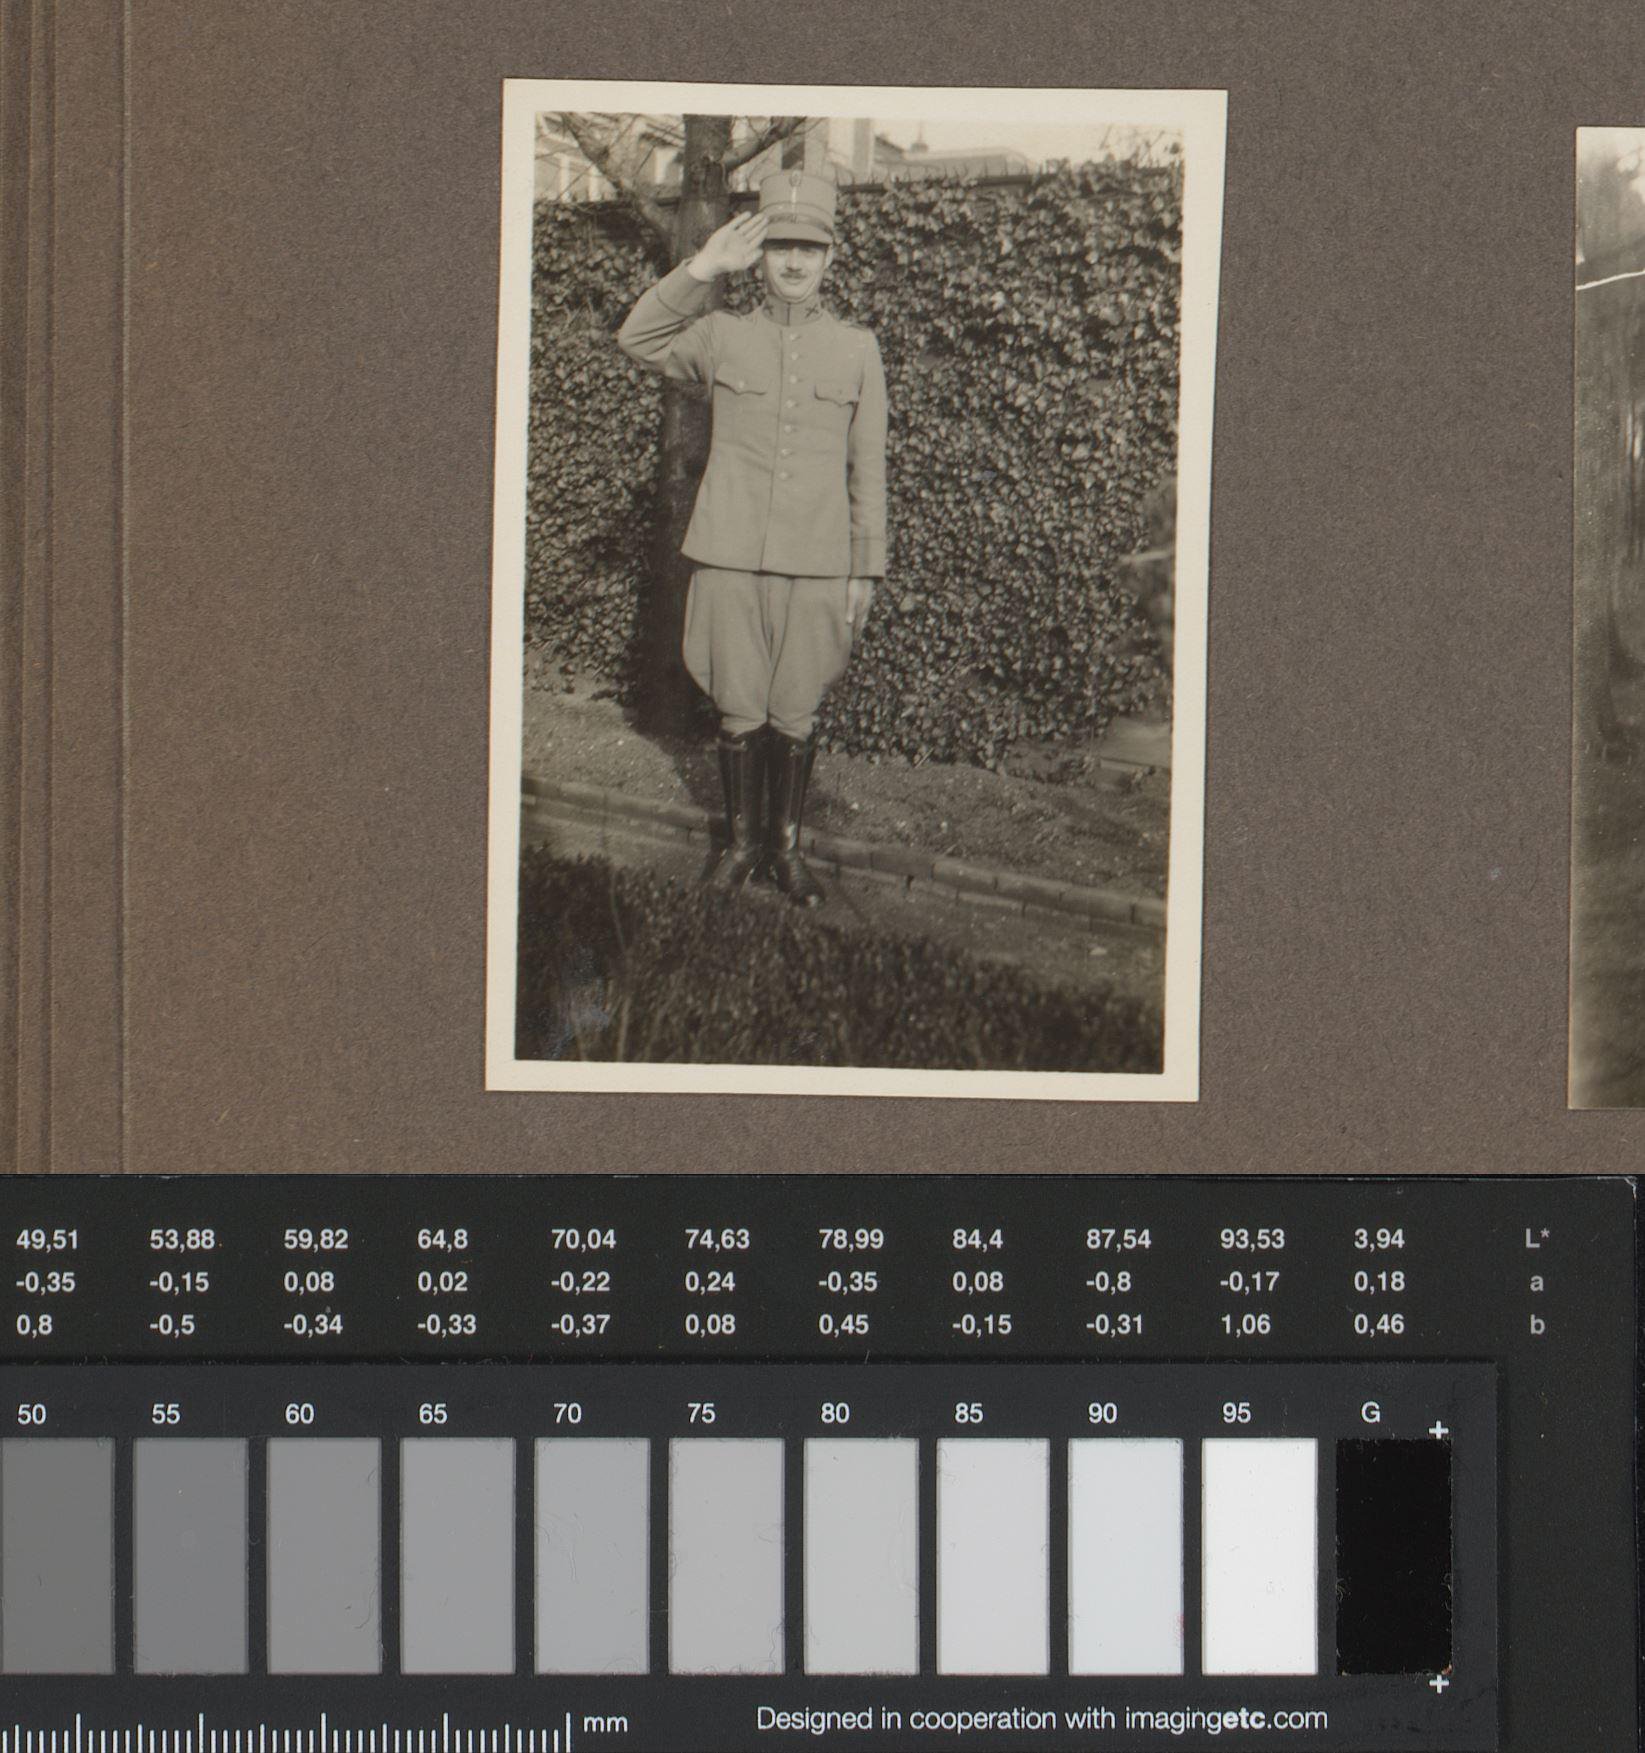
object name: album leaf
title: Portret van Johannes van Zijll de Jong in legeruniform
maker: Anonymous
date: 1930-1935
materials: paper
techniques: gelatin silver print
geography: netherlands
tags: historical persons, (military) uniforms, netherlands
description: Gezien het uniform kon de rang van de geportretteerde mogelijk wachtmeester van het Korps Rijdende Artillerie zijn geweest.